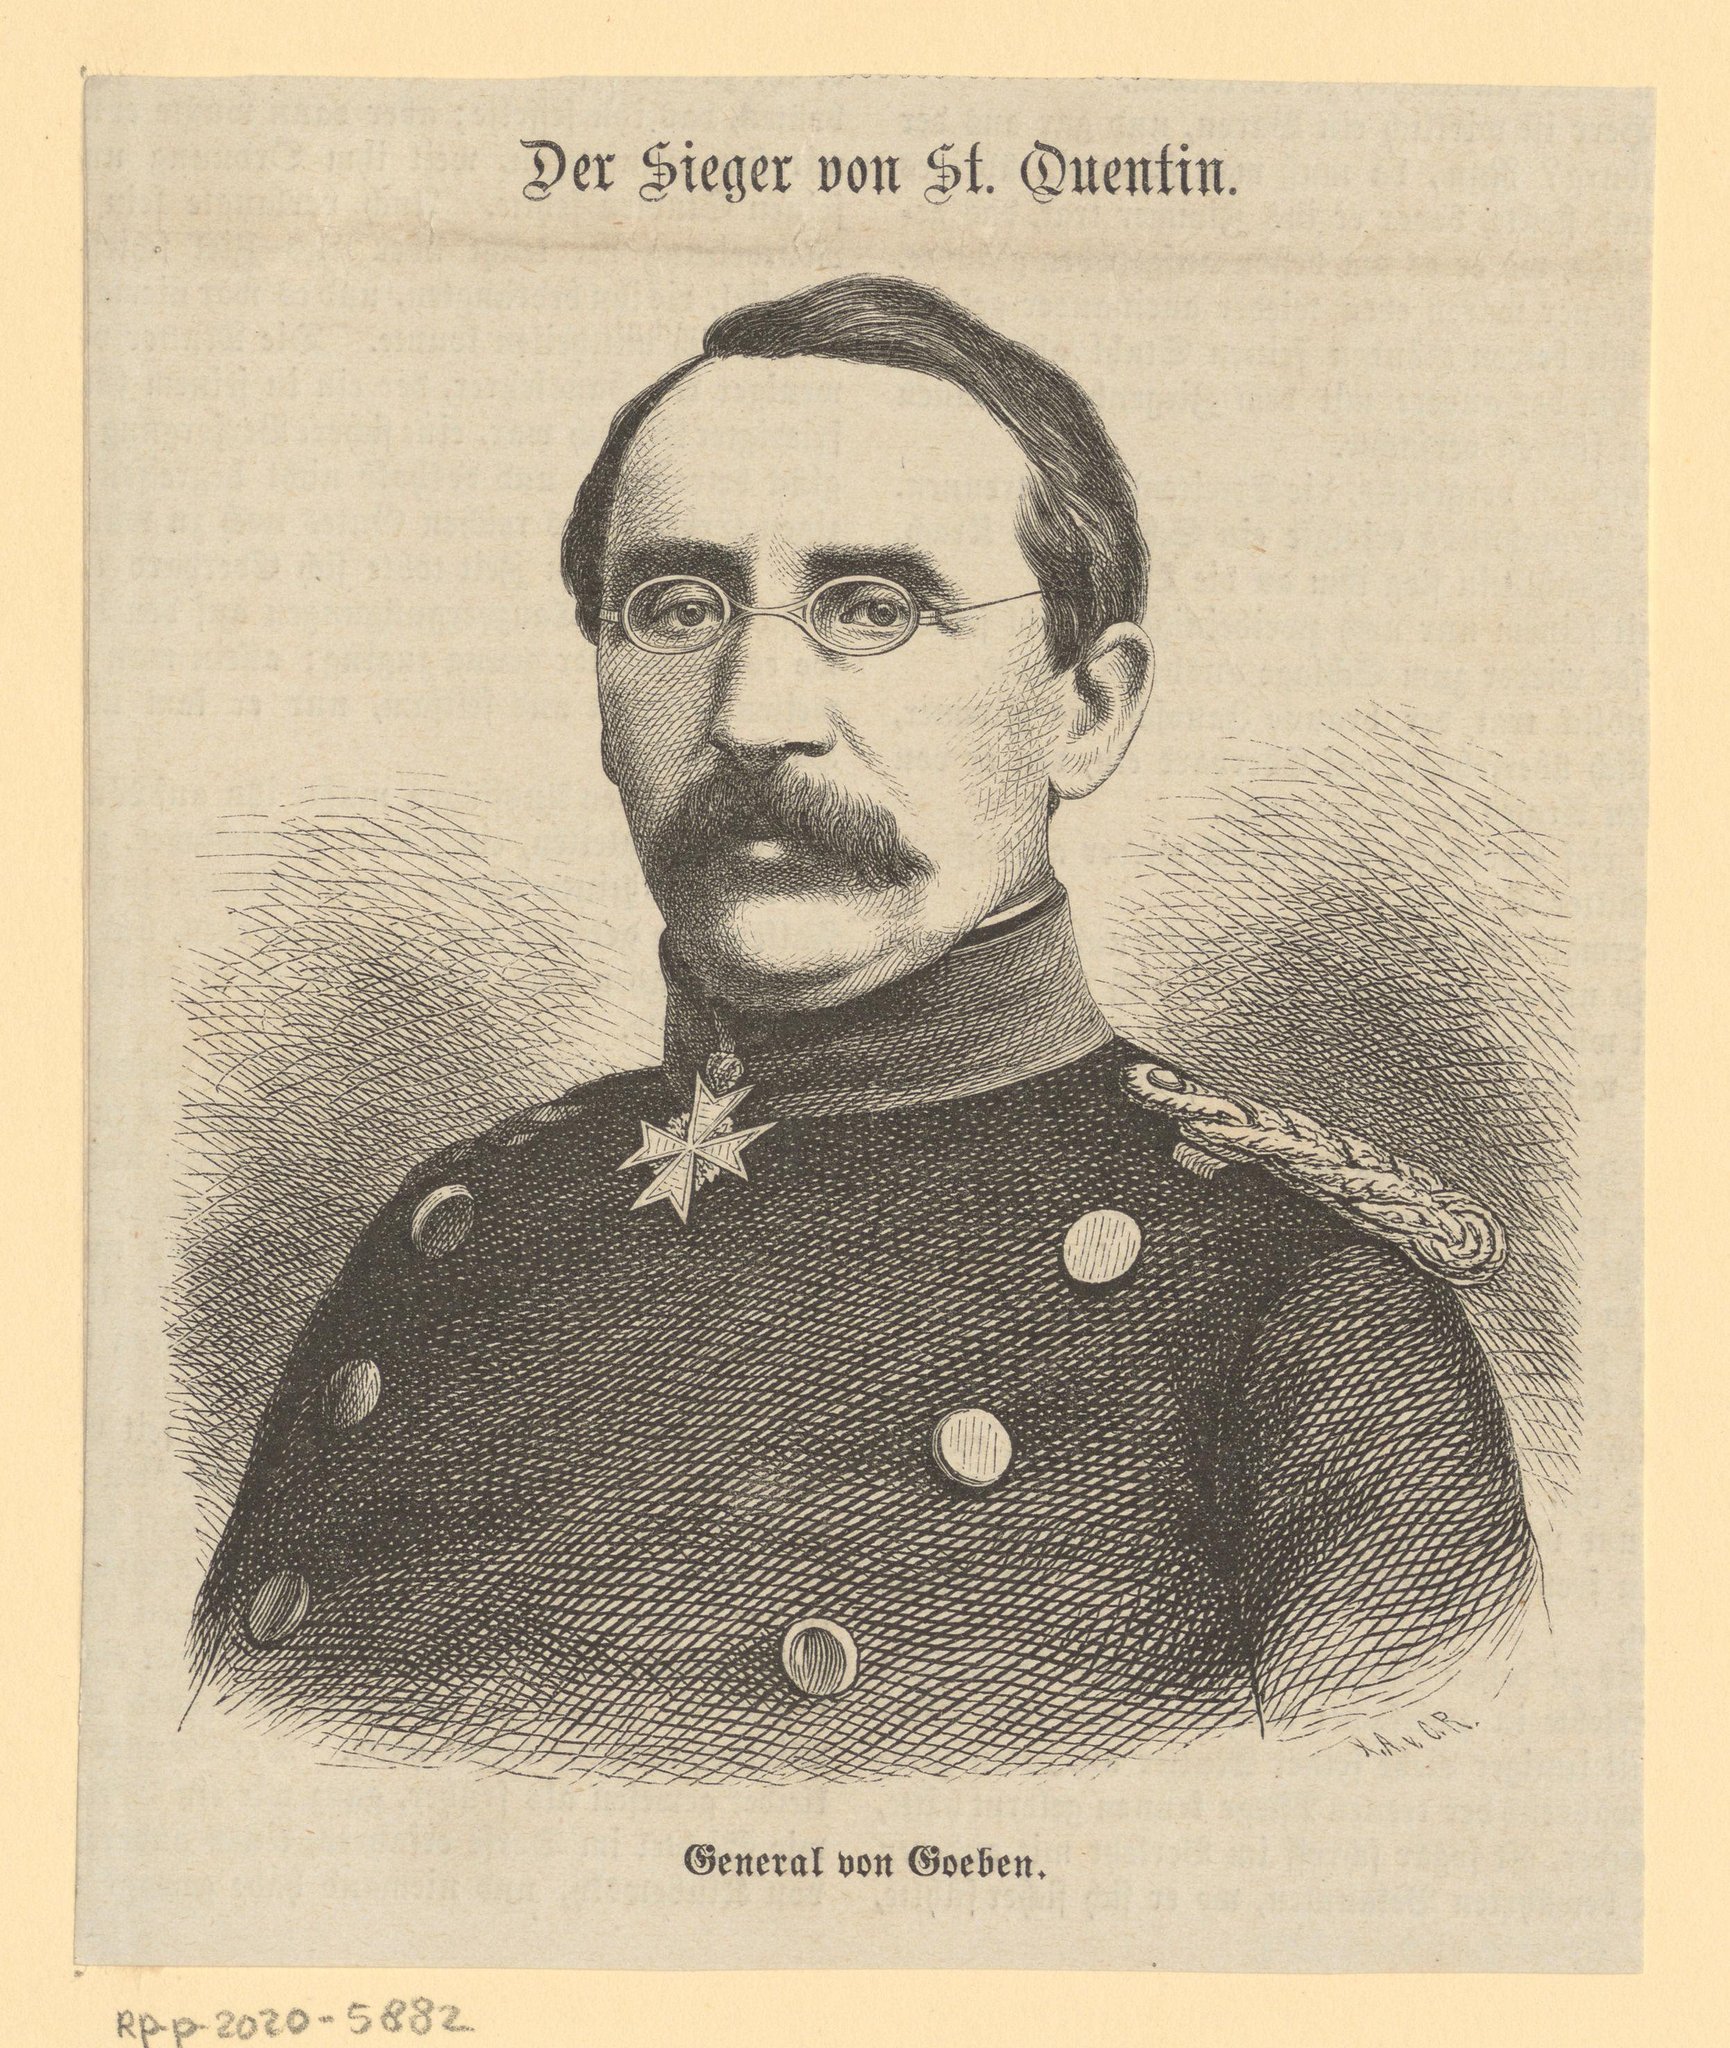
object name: print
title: Portret van August Karl von Goeben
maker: monogrammist xa v cr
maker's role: print maker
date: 1873-1880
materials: paper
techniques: letterpress printing, engraving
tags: commander-in-chief, general, marshal, historical persons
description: Prent mogelijk uit: Müller, Wilhelm. Die Jahre 1871 und 1872. S.l.s.n, 1873.